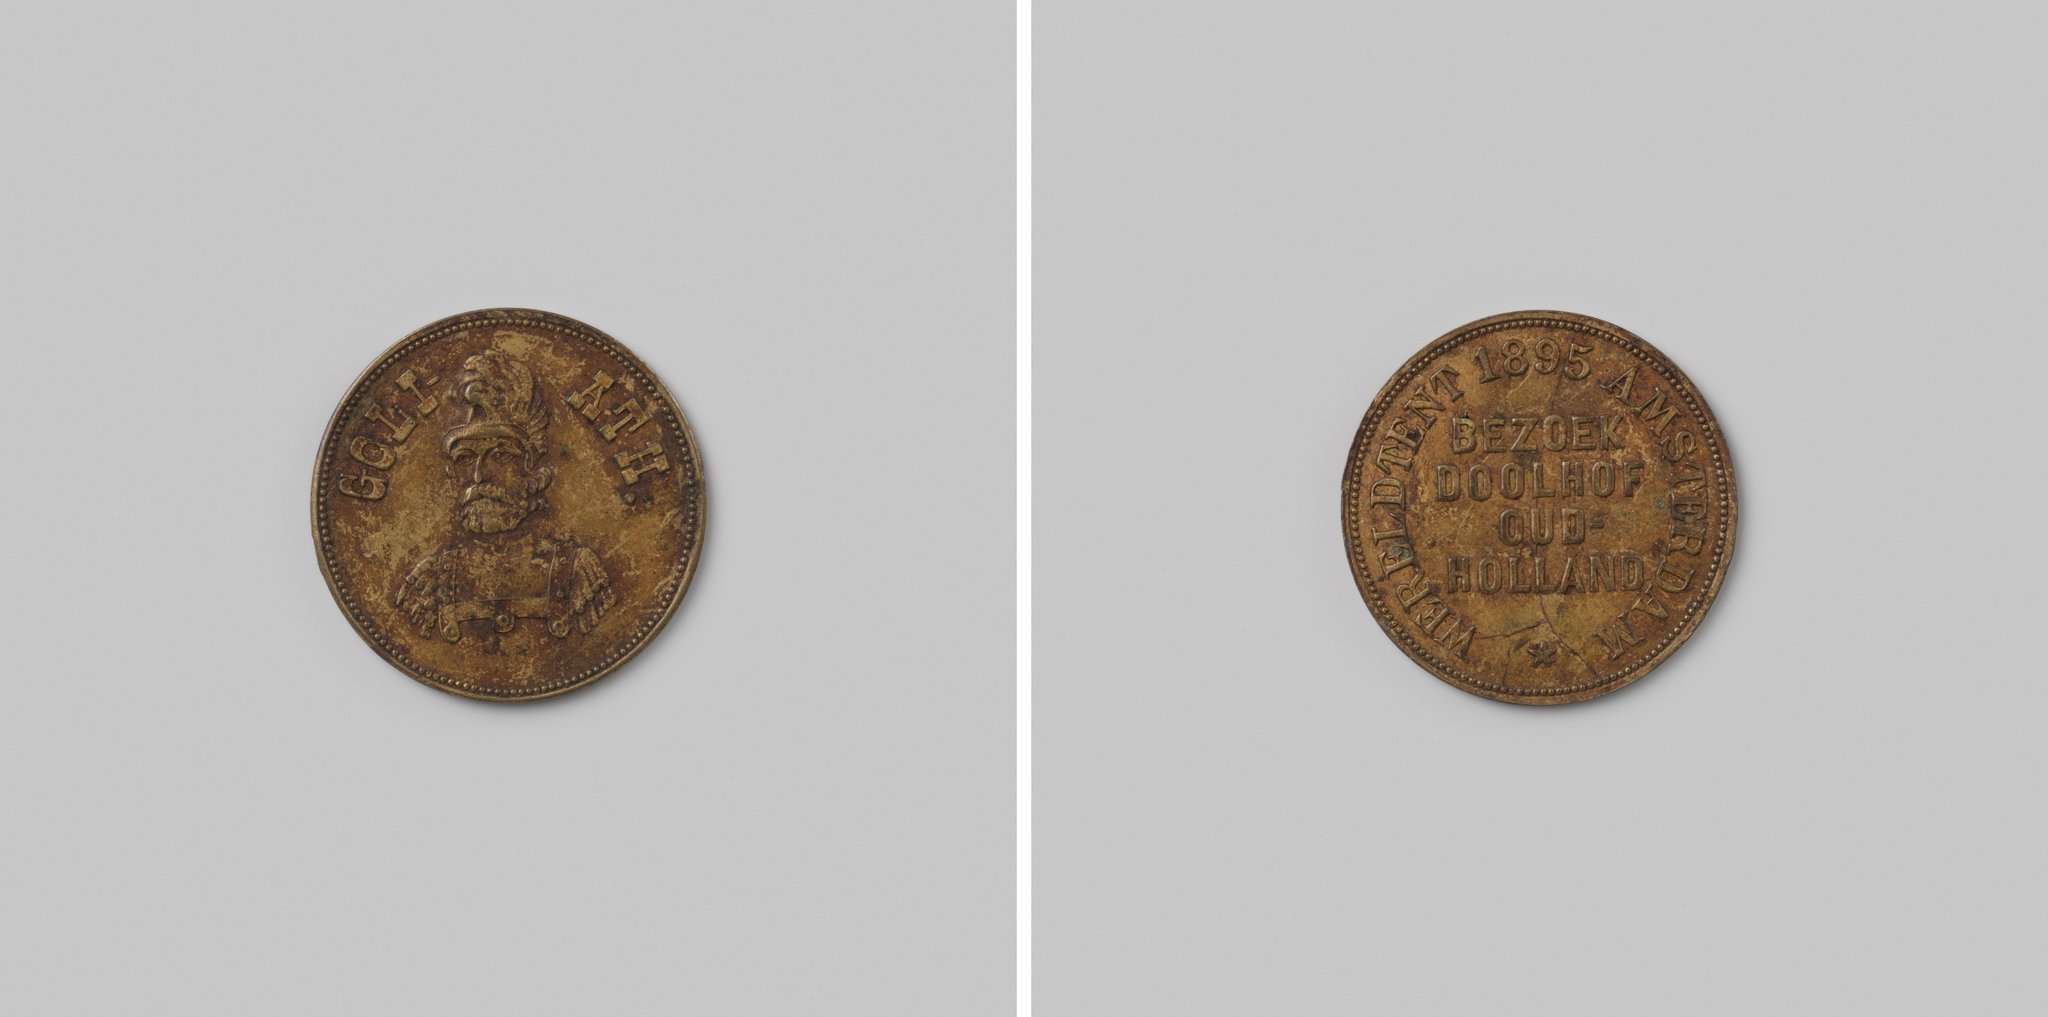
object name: toegangspenning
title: Doolhof Oud-Holland, attractie op de wereldtentoonstelling te Amsterdam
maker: Anonymous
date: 1895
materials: copper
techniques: striking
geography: netherlands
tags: amsterdam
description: Koperen penning. Voorzijde: borststuk man met gepluimde helm binnen omschrift. Keerzijde: opschrift binnen omschrift